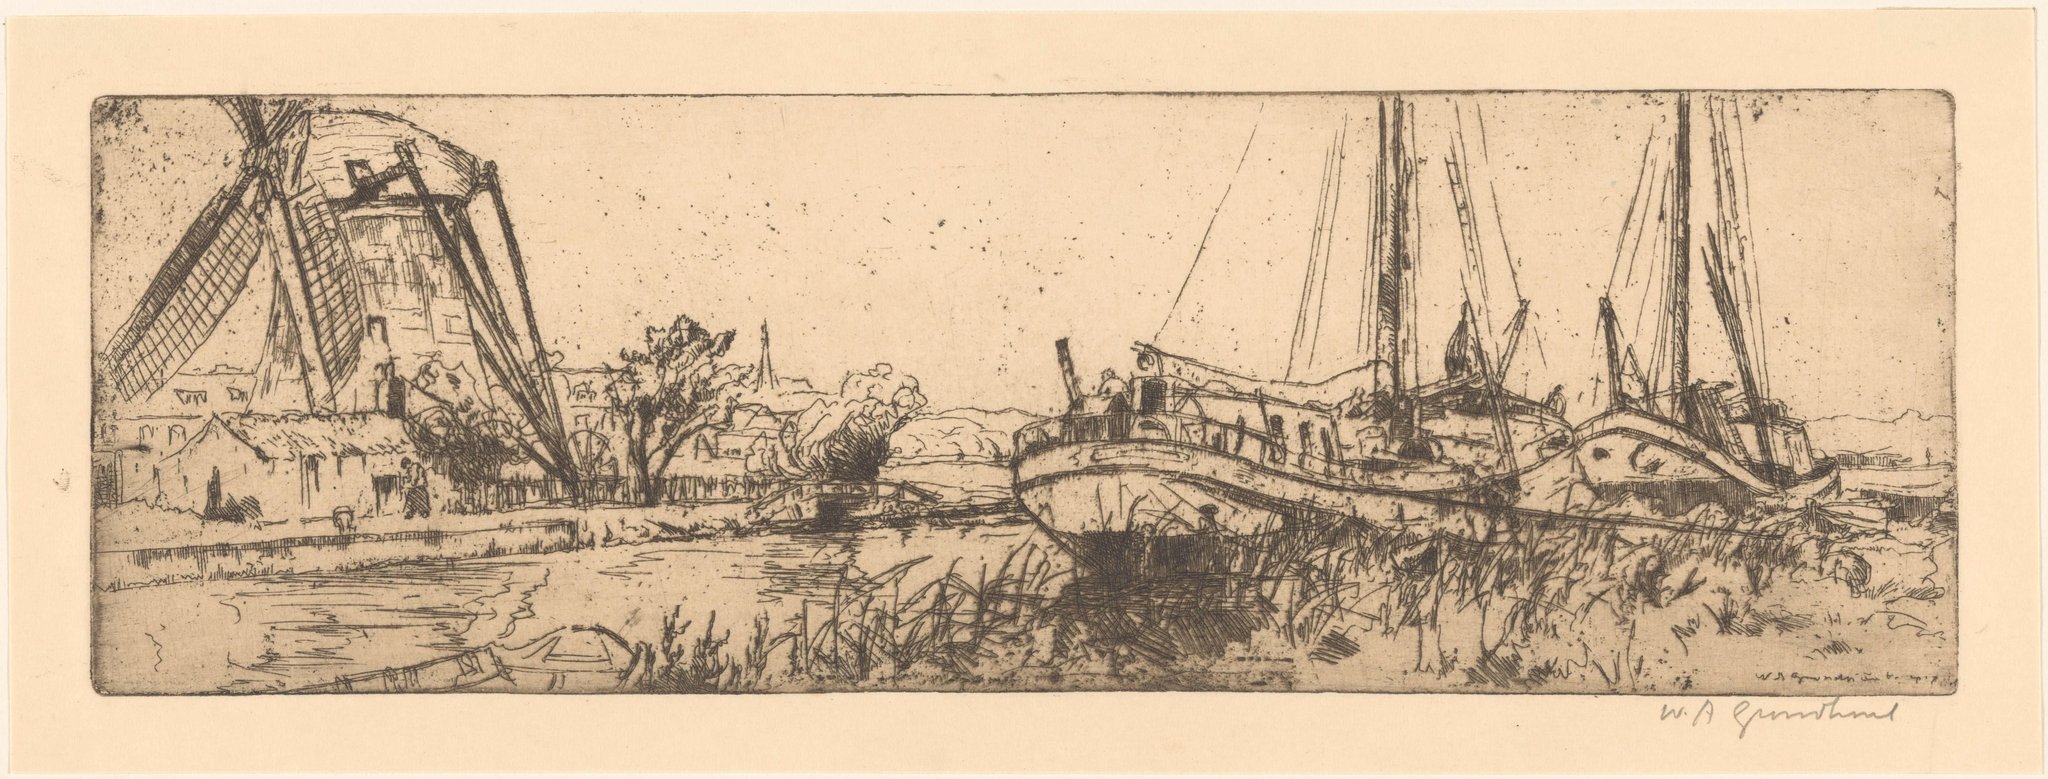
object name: print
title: De Vliet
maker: willem adrianus grondhout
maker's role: draughtsman, painter, print maker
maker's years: 1878-1934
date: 1888-1931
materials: paper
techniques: etching, intaglio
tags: ships (in general), windmill in landscape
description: Een molen langs de Vliet nabij Den Haag. Rechts twee afgemeerde schepen.